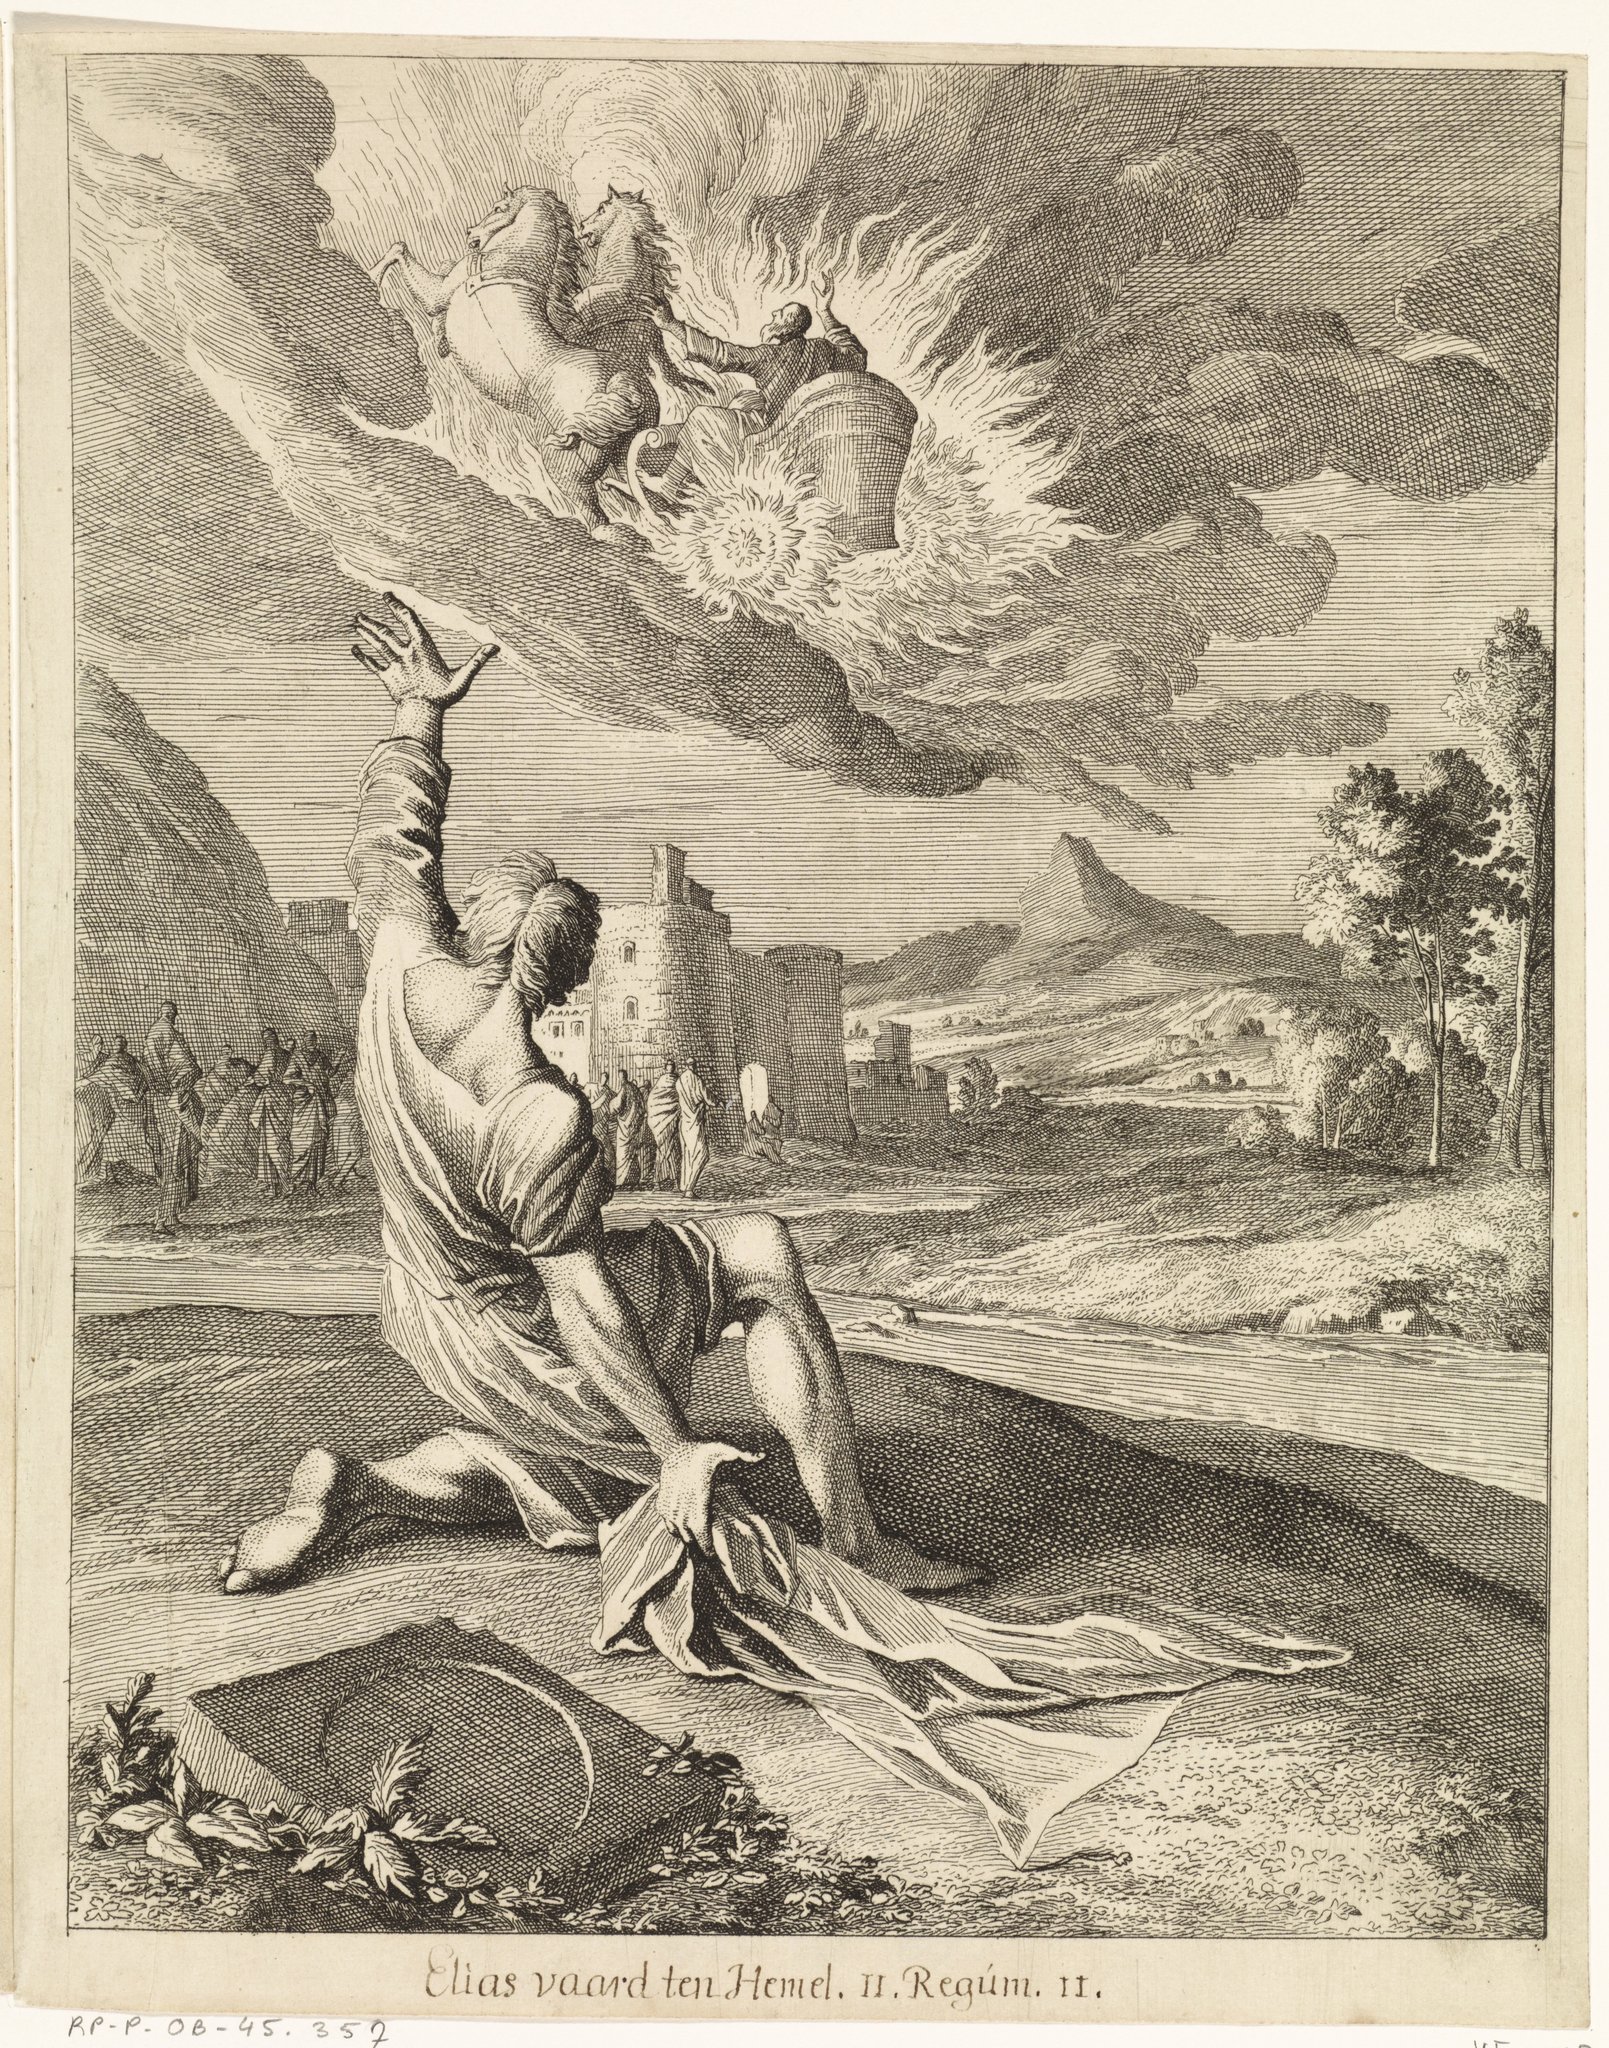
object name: print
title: Elisa ziet de hemelvaart van Elia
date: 1708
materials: paper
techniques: etching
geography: nuremberg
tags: a chariot, horses of fire and a whirlwind appear and elijah is carried up into heaven; elijah's cloak falls (or he hands it over to elisha)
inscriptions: collector's mark: Lugt 2228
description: Proefdruk van een prent welke is opgenomen als illustratie in: Historiae Celebriores Veteris Testamenti. Christoph Weigel, 1708.